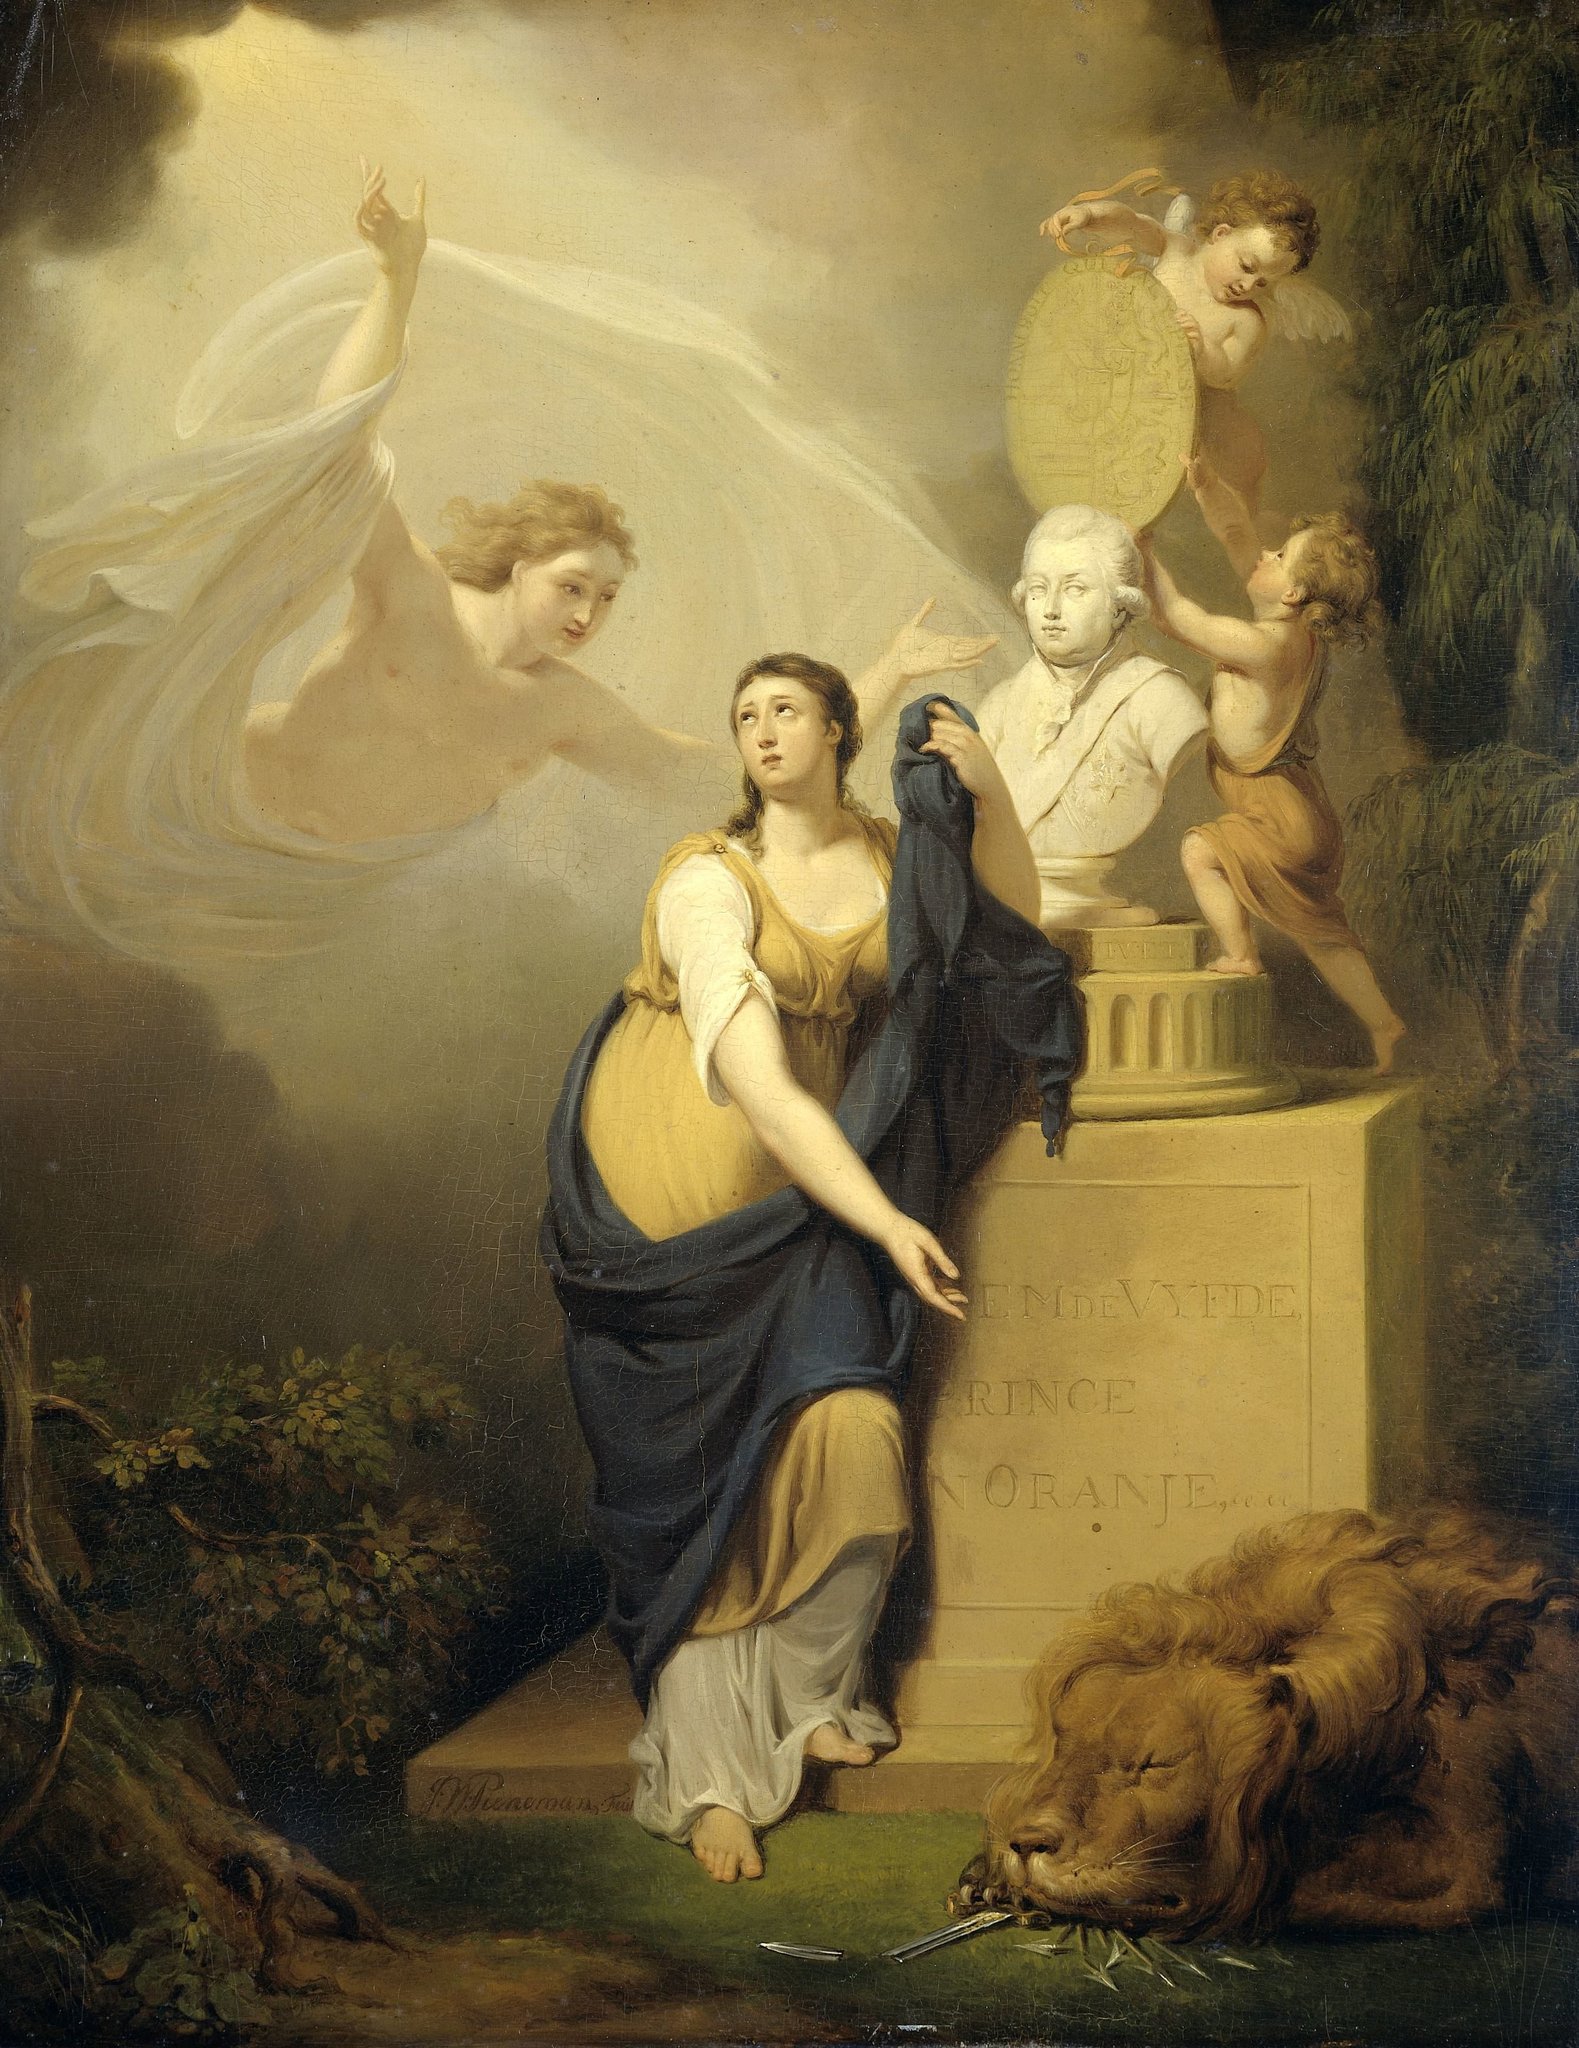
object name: painting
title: Allegory of the Death of William V, Prince of Orange, 1806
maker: jan willem pieneman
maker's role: draughtsman, painter, print maker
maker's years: 1779-1853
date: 1806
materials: oil, panel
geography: netherlands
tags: the hague, william v (prince of orange), personifications of countries, nations, states, districts, etc., grave, tomb, piece of sculpture, reproduction of a piece of sculpture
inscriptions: signature: ‘J.W. Pieneman Fecit’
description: Allegorie op de dood van Willem V, prins van Oranje, 1806. De Nederlandse Maagd staat treurend bij het graf van de prins. Zij wordt getroost door een engel. Op het graf staat een portretbuste, twee putti dragen het wapenschild. Rechts onder de Nederlandse Leeuw, slapend op gebroken wapens.